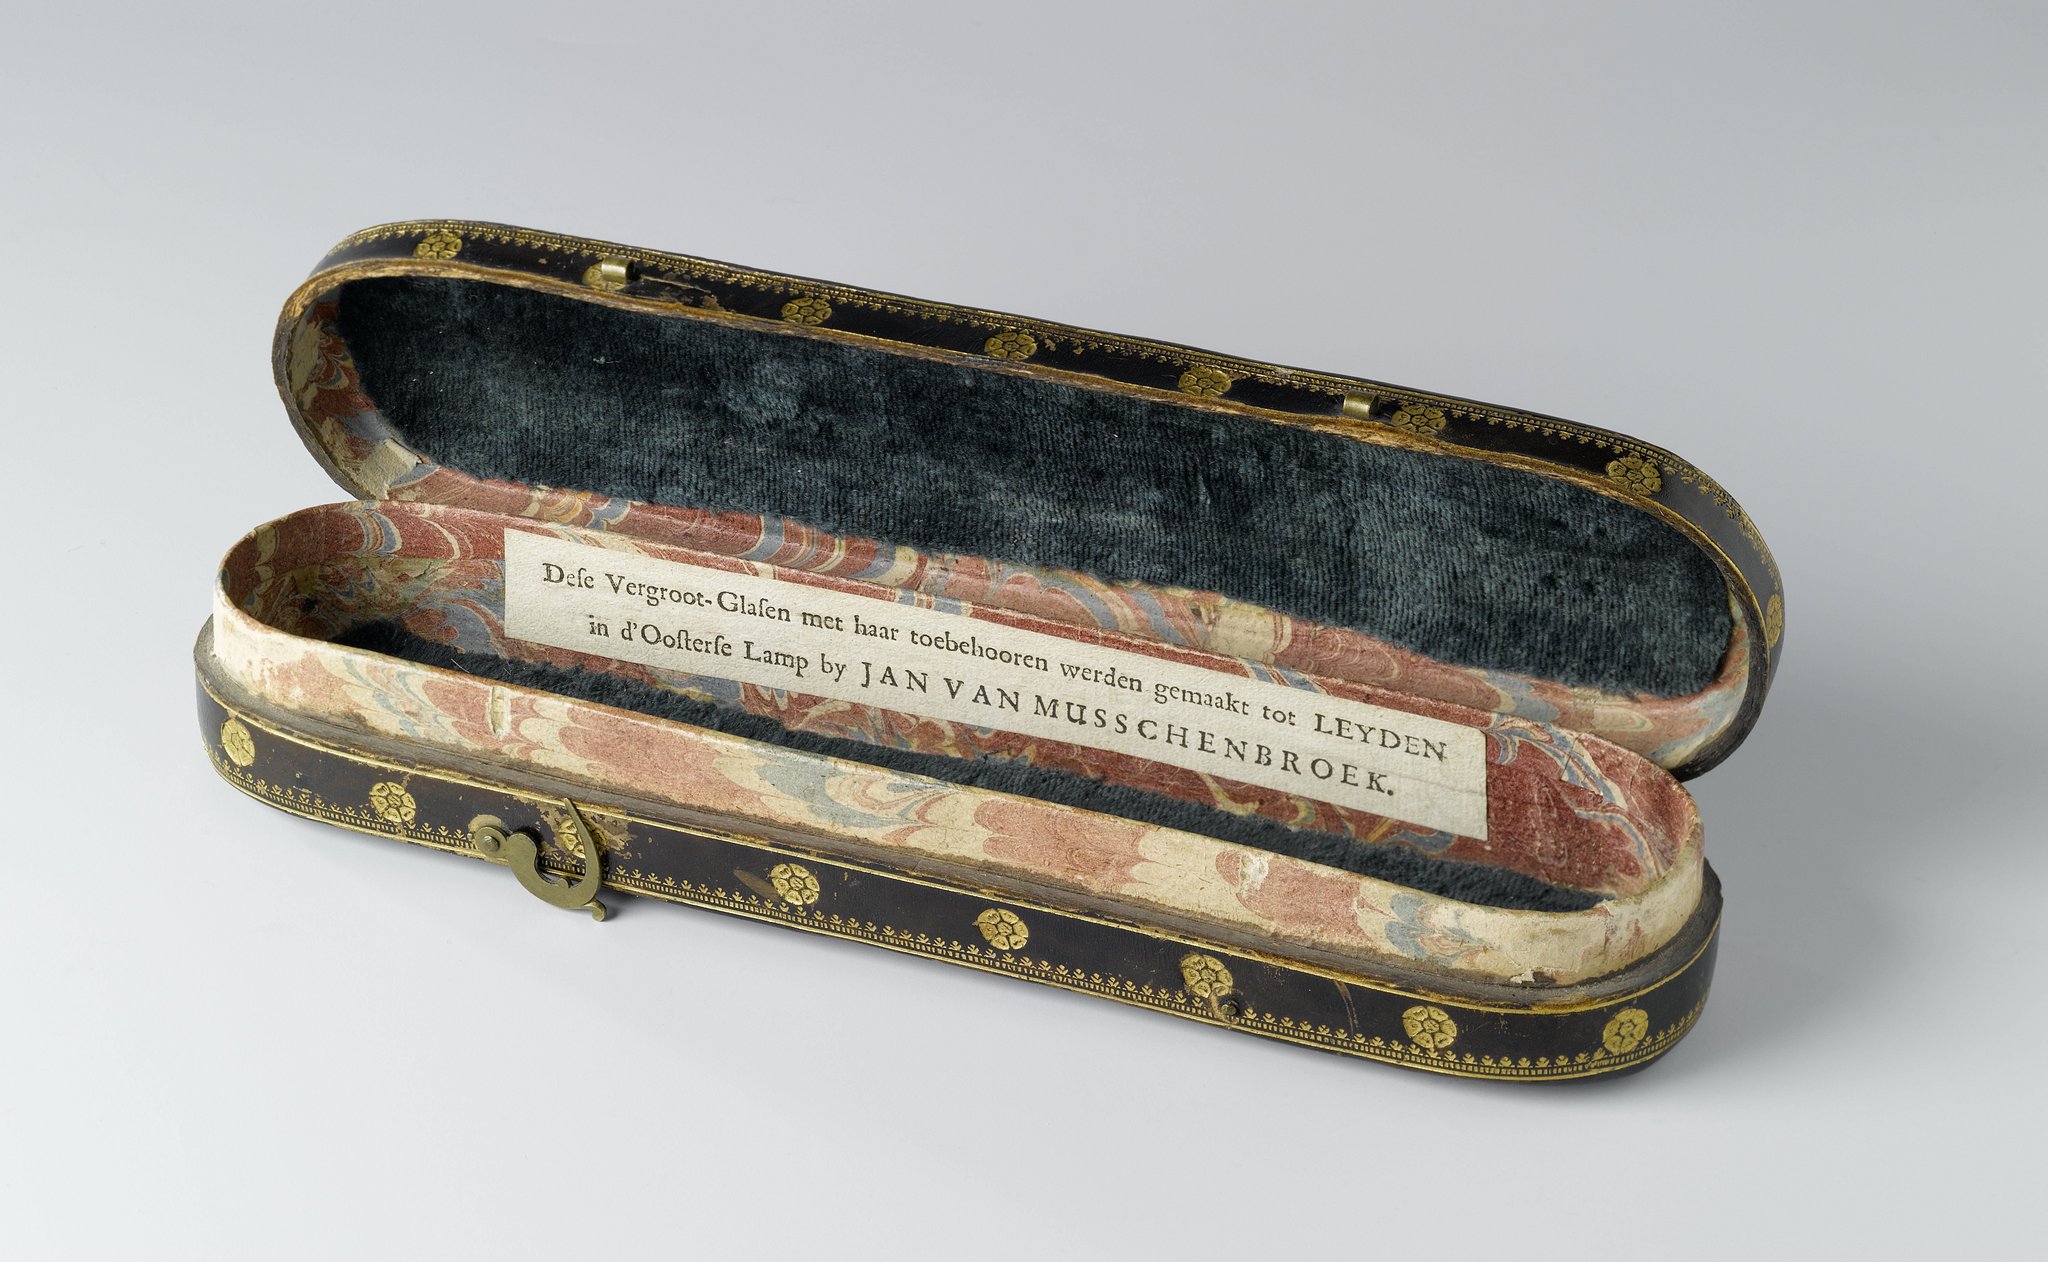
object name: case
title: Brillendoos van dik papier met donkerbruin leer bekleed en bedrukt met vergulde florale ornamenten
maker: jan van musschenbroek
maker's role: instrument maker, physicist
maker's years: 1687-1748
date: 1710-1725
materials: copper, gold leaf, leather, paper, velvet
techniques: forging, marbling, printing, tanning, weave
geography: leiden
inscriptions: name: ‘'Deze vergrootglazen met haar toebehooren werden gemaakt tot Leyden in d'Oosterse Lamp van Jan van Musschenbroek'’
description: Brillendoos in een langwerpige vorm met afgeronde hoeken, van dik papier met donkerbruin leer bekleed en bedrukt met vergulde florale ornamenten. Op de deksel een rand van fijne bloemranken dat een rechthoekig vlak met symmetrisch geordende oriëntaals aandoende motieven omlijst. Rondom de zijkant van de doos een baan met enkele, gestileerde bloemen. Een gedrukt dubbel ruitpatroon siert de onderkant van de doos, die verder ongedecoreerd is gelaten. Sluiting door middel van twee koperen haken en ogen, waarvan een haak ontbreekt. De binnenzijde is voorzien van gemarmerd papier, met tegen de deksel en op de bodem donkerblauwe fluwele bekleding. Binnenin de doos een cylindervormige koker van dik papier, bekleed met zwart leer met tegen de uiteindenden een vergulde rand, waarin glazen haarbuisjes (?).